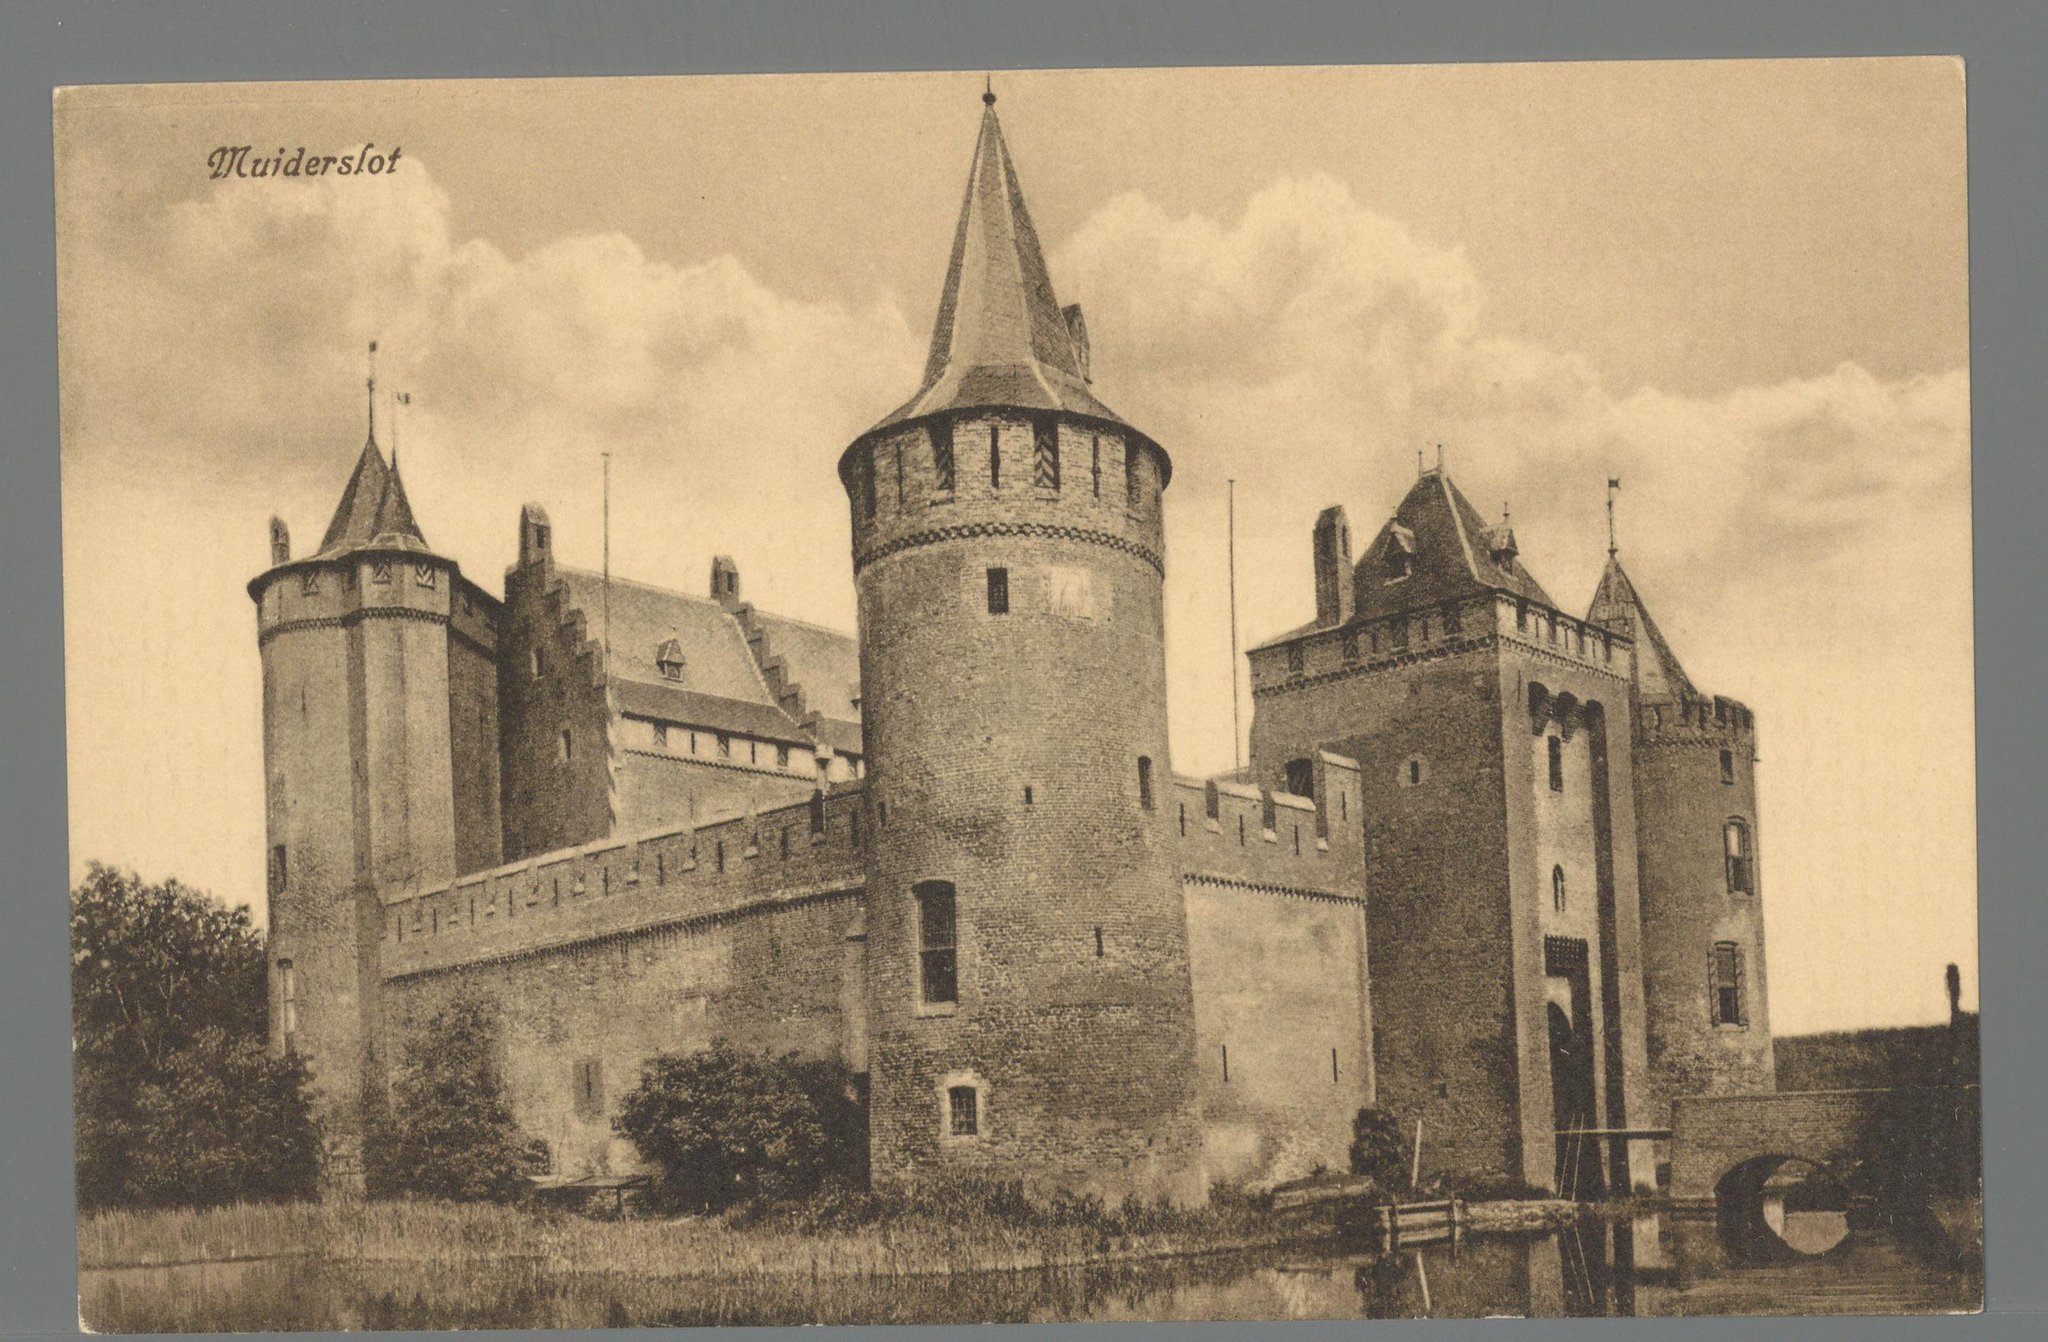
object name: photomechanical print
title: Muiderslot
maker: Anonymous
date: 1906-1930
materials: cardboard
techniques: photograph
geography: muiden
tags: castle